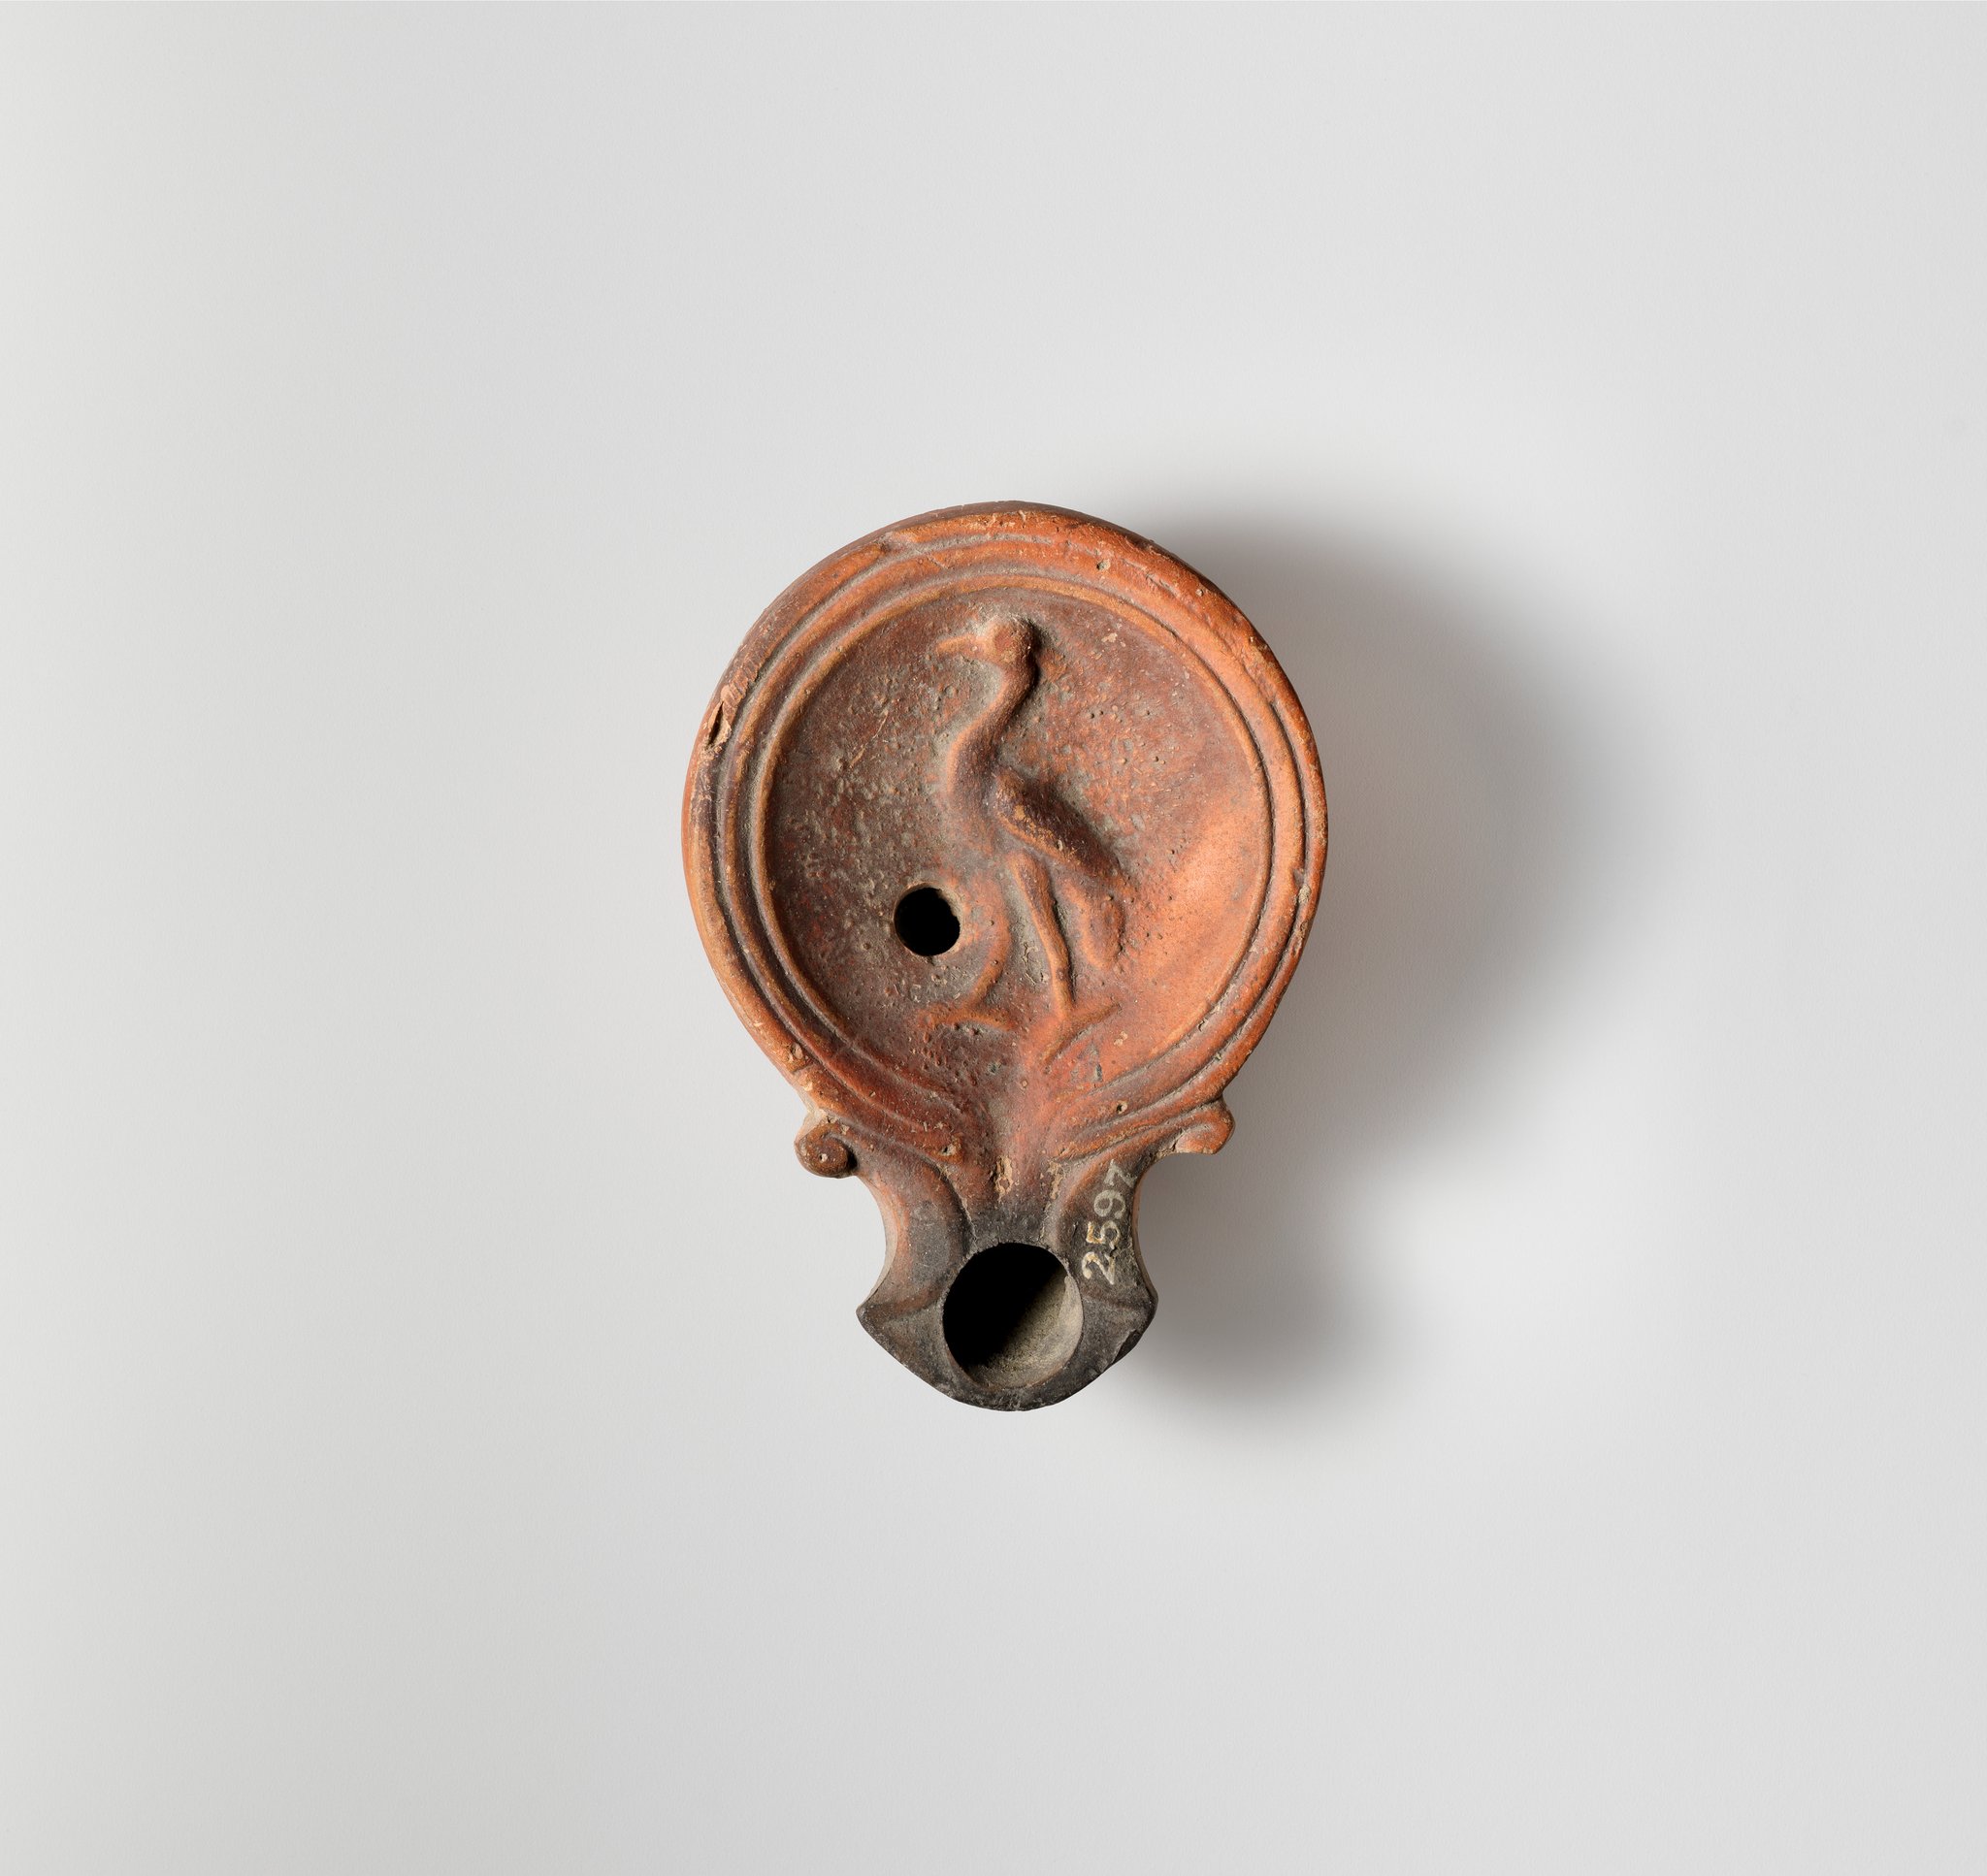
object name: lamp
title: Terracotta oil lamp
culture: roman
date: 100 BCE-100 CE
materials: terracotta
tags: birds